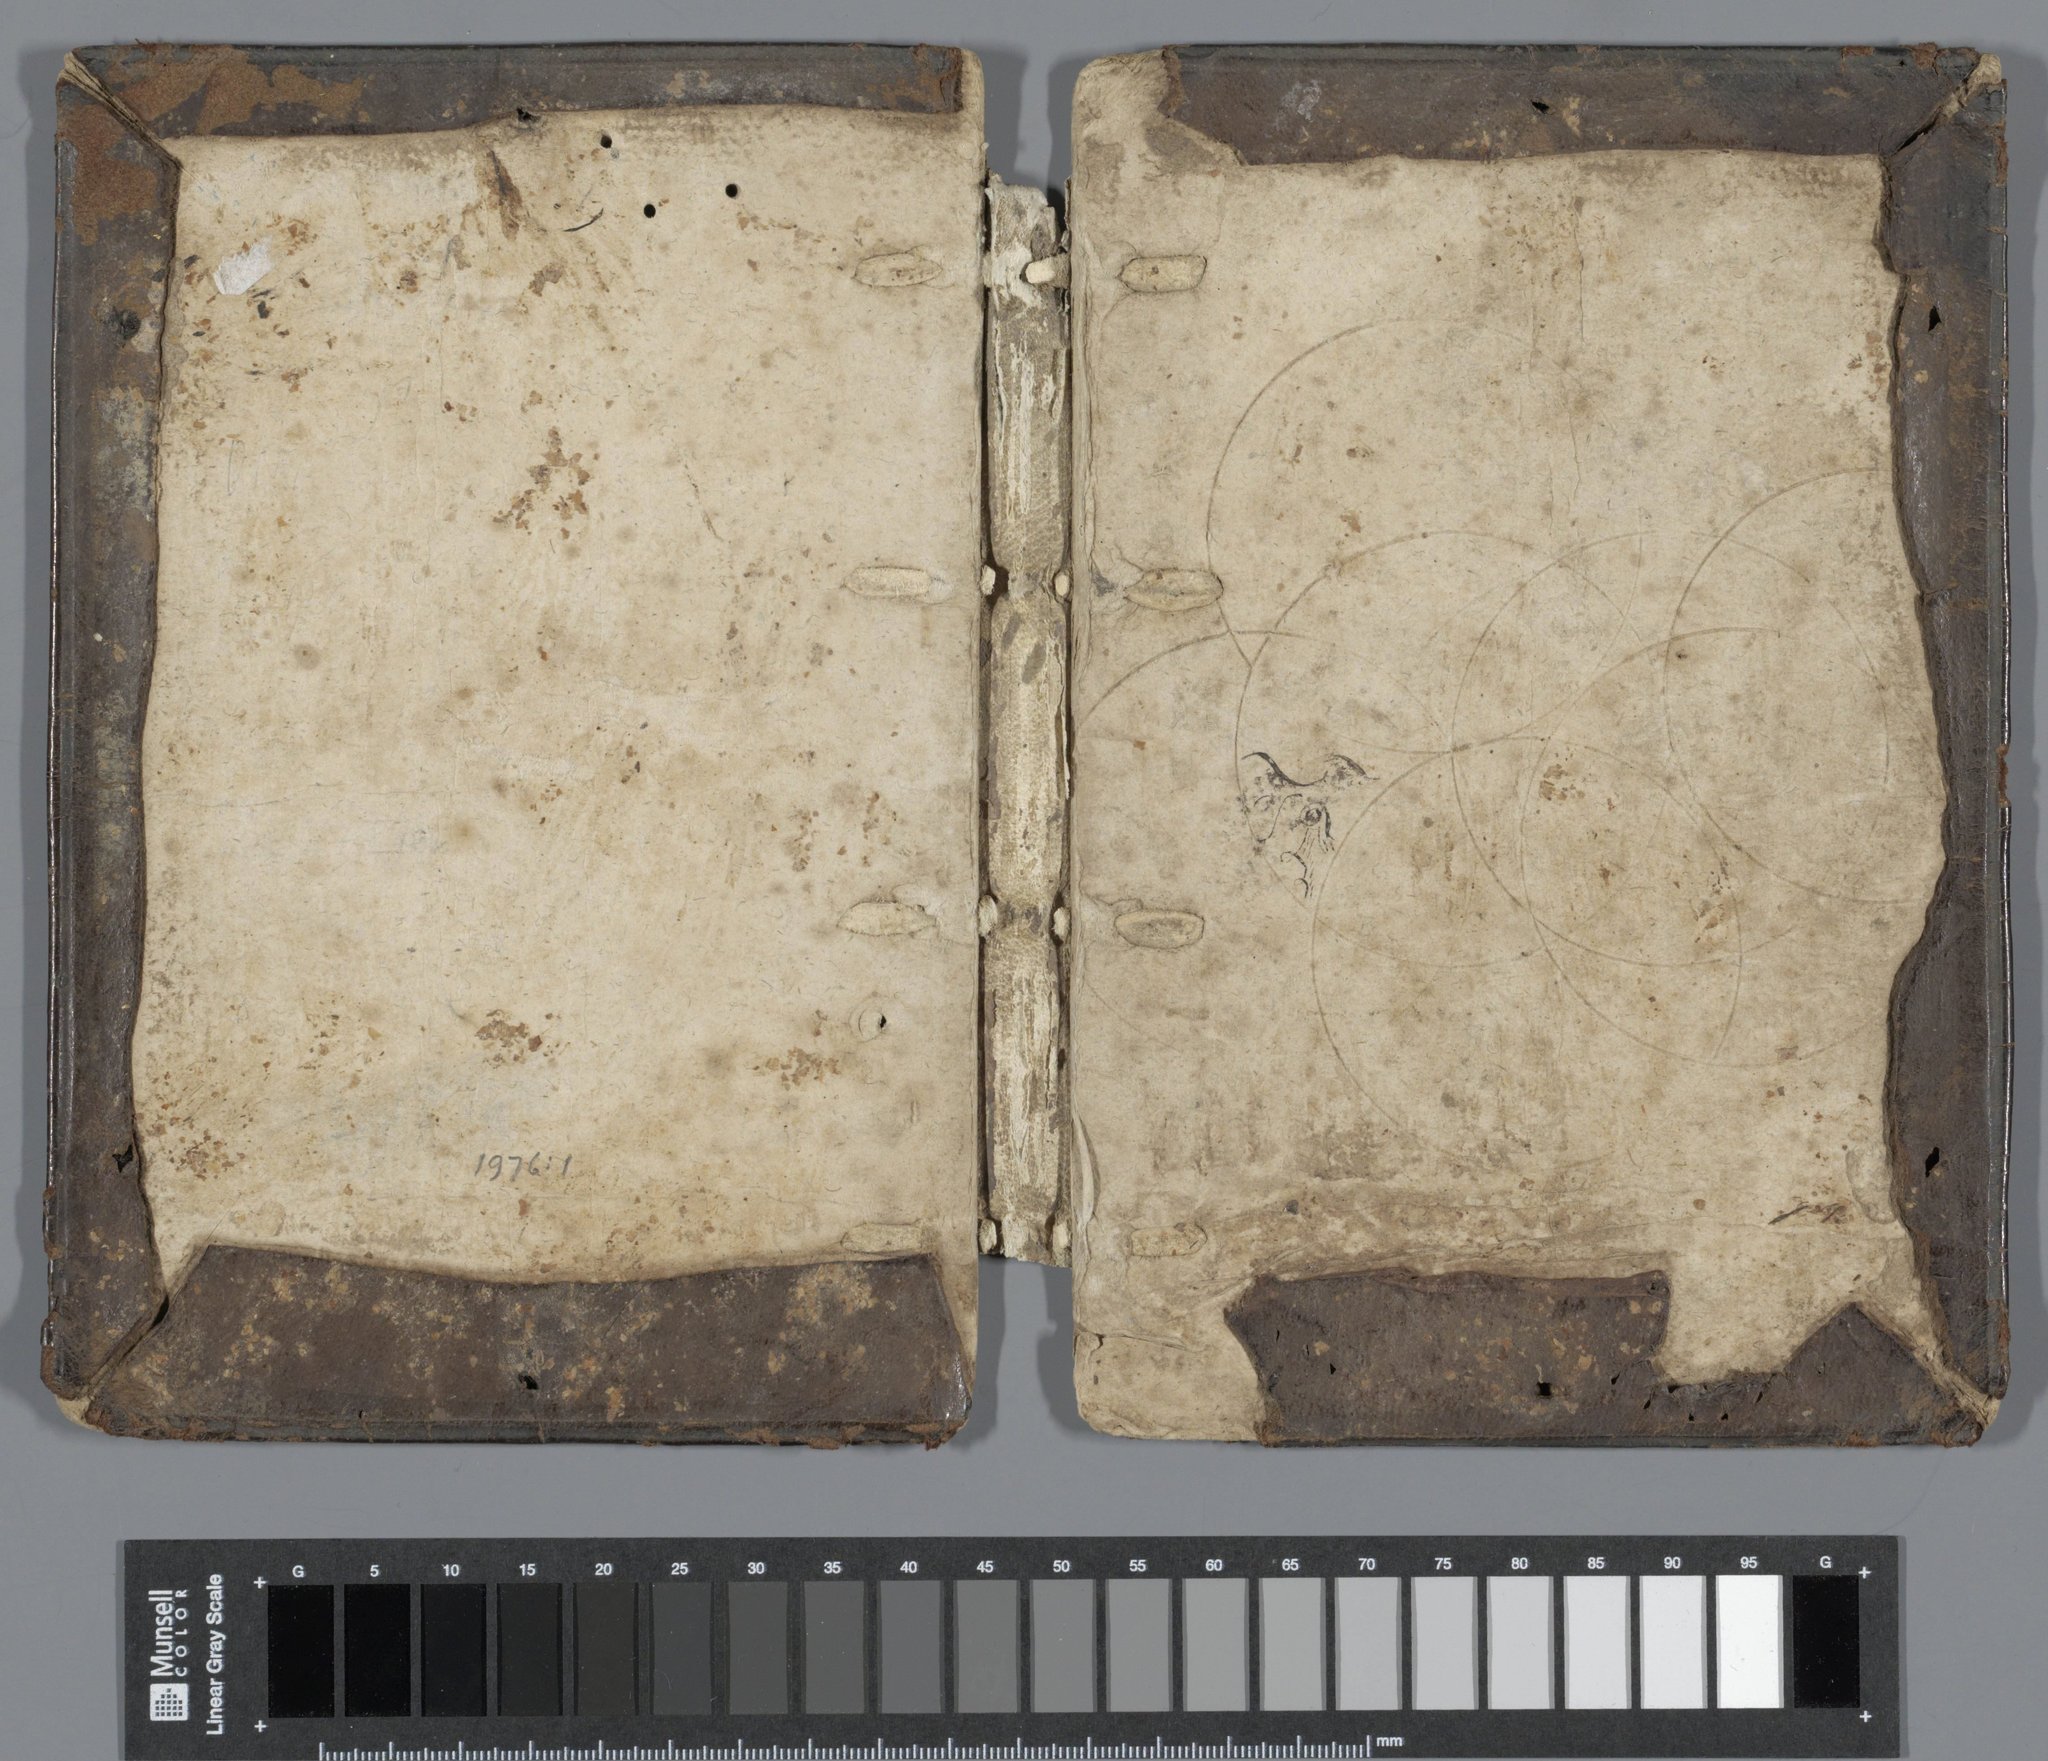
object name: album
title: Album met tekeningen van edelsmeedkunst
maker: jacques androuet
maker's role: draughtsman, print maker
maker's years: 1515-1584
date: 1543-1553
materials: ink, leather, parchment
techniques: brush, pen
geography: france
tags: altar with dossel (dorsal), 'reredos', altar-screen, retable, container of ceramics: jar, jug, pot, vase, dinner-service, container of stone: stone vase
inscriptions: check stamp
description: Album bestaande uit een band met twee bladen, een schutblad en zeventien apart opgezette bladen met tekeningen van edelsmeedkunst, waaronder vazen, schalen, kannen en retabels.